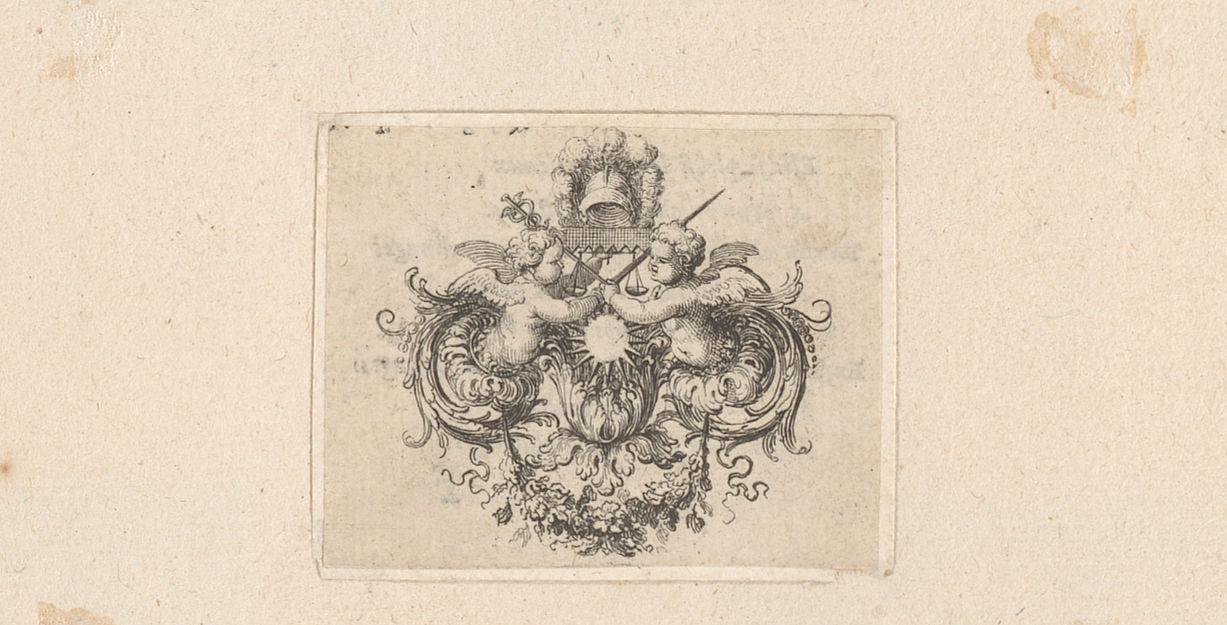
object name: album leaf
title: Cul-de-lampe met twee putti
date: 1669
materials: paper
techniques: etching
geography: paris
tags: cupids: 'amores', 'amoretti', 'putti'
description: Prent uit: Le Laboureur, Louis. La Promenade de Saint-Germain. A Mademoiselle de Scudery. Parijs: Guillaume de Luynes, 1669.